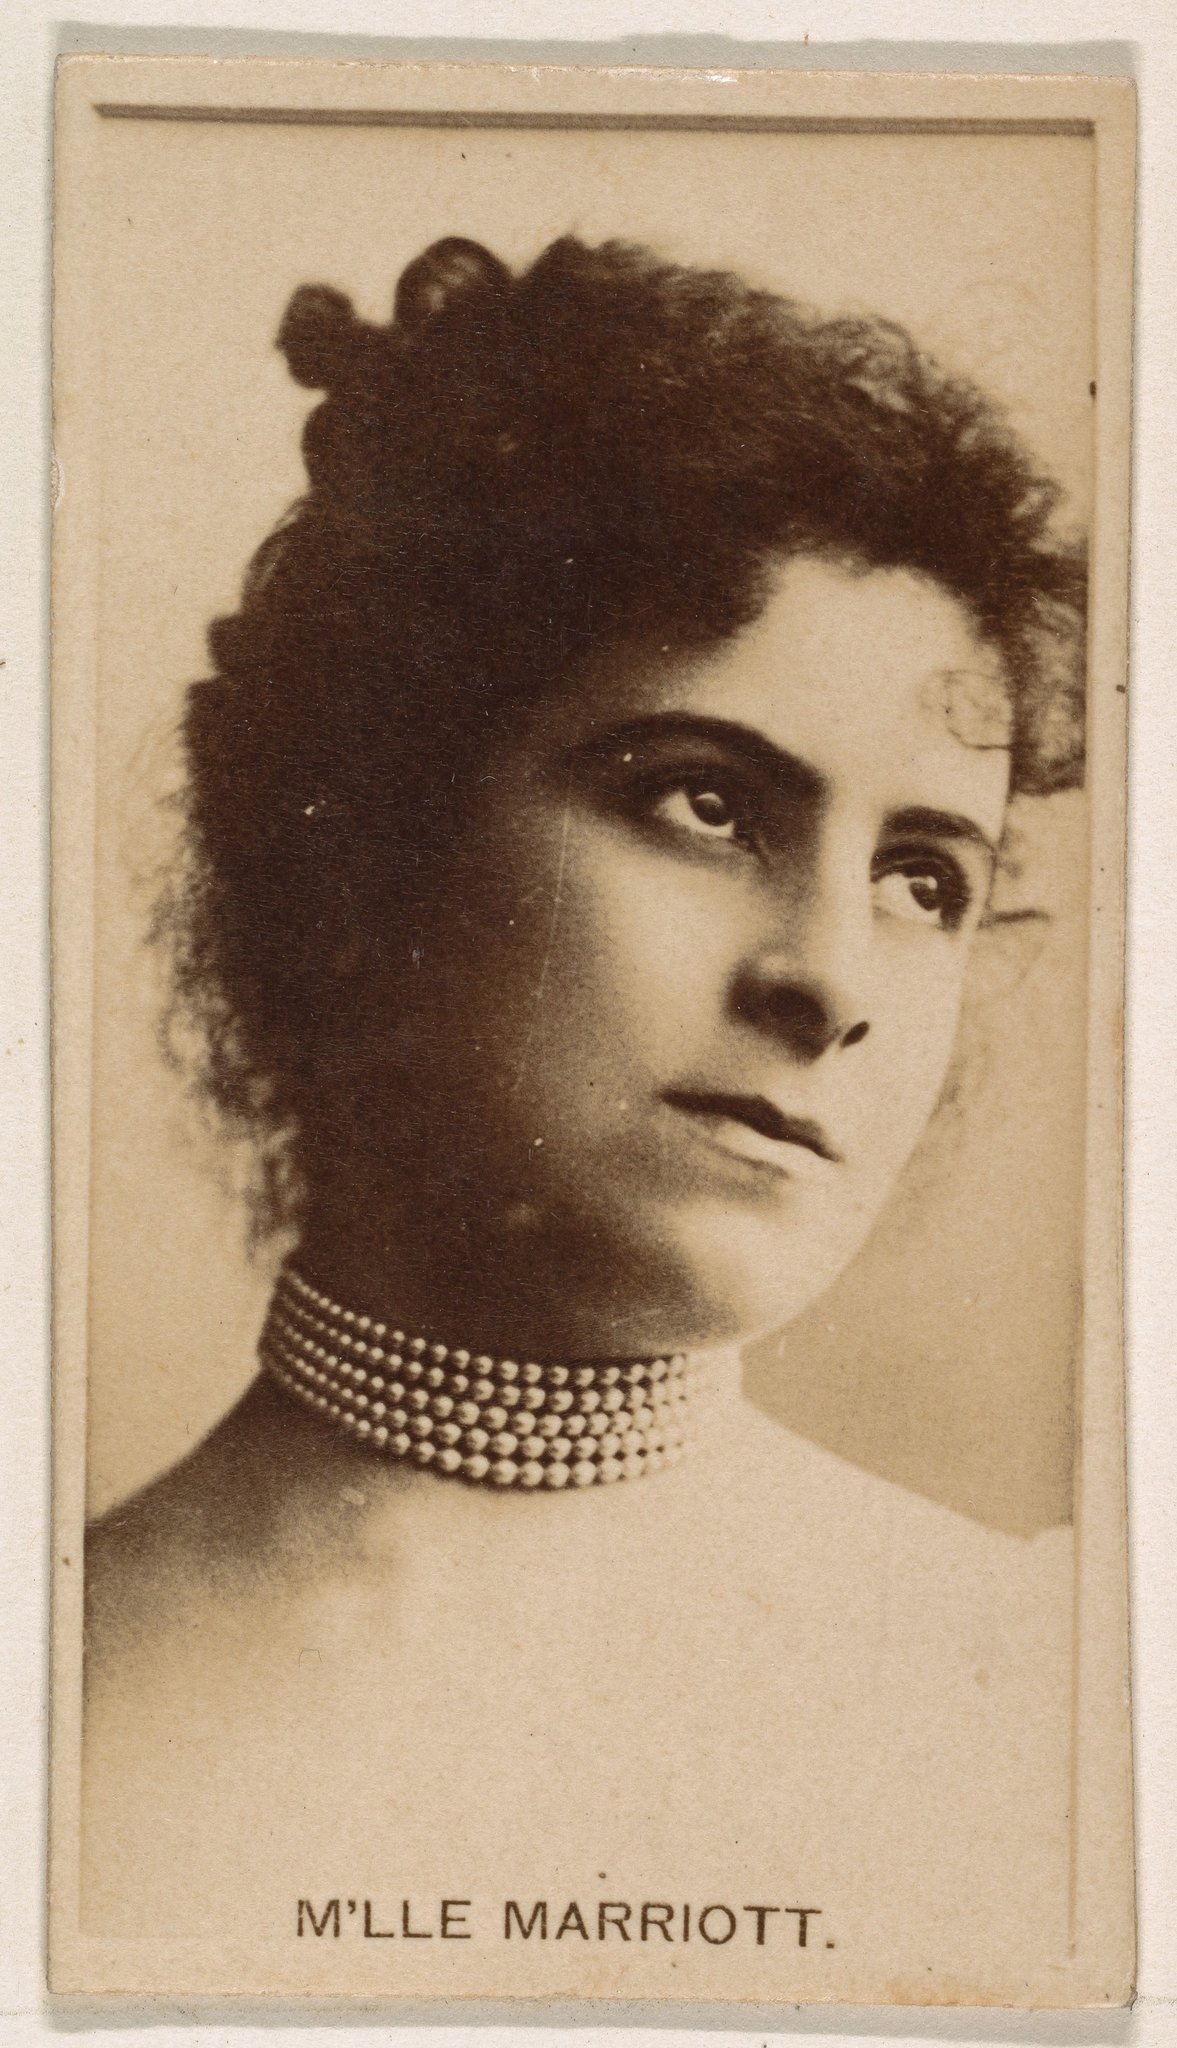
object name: photograph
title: M'lle Marriott, from the Actresses series (N245) issued by Kinney Brothers to promote Sweet Caporal Cigarettes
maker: kinney brothers tobacco company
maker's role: publisher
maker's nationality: american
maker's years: 1869-2011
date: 1890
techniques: albumen silver print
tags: portraits,women,actresses